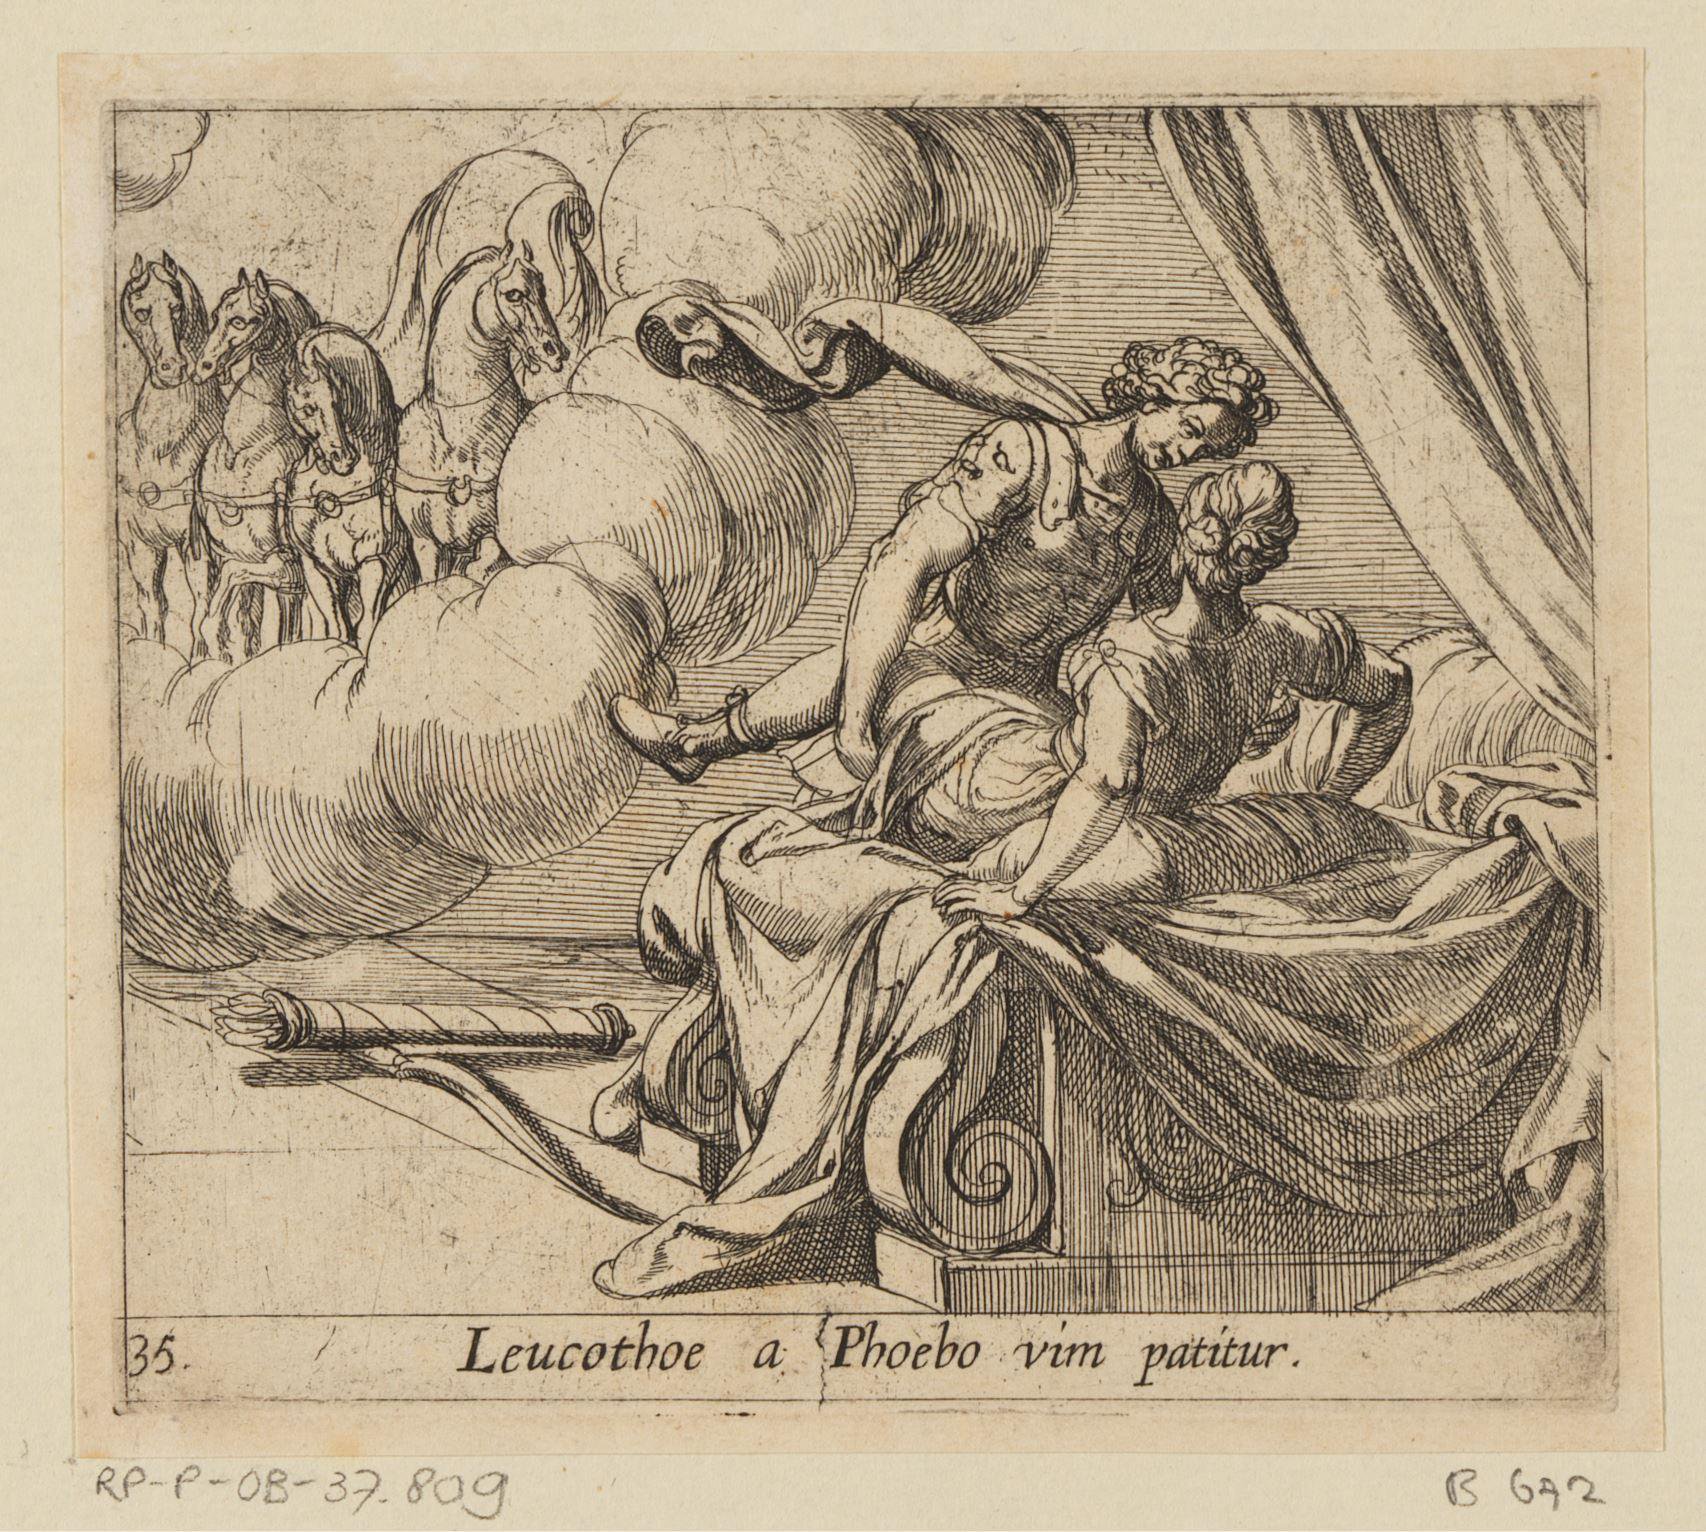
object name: print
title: Metamorfosen van Ovidius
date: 1606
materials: paper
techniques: etching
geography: antwerp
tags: (story of) apollo (phoebus)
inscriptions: collector's mark: Lugt 240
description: Apollo bedrijft de liefde met Leucothoe op een bed. Op de achtergrond links de zonnewagen. Titel in het Latijn in ondermarge.